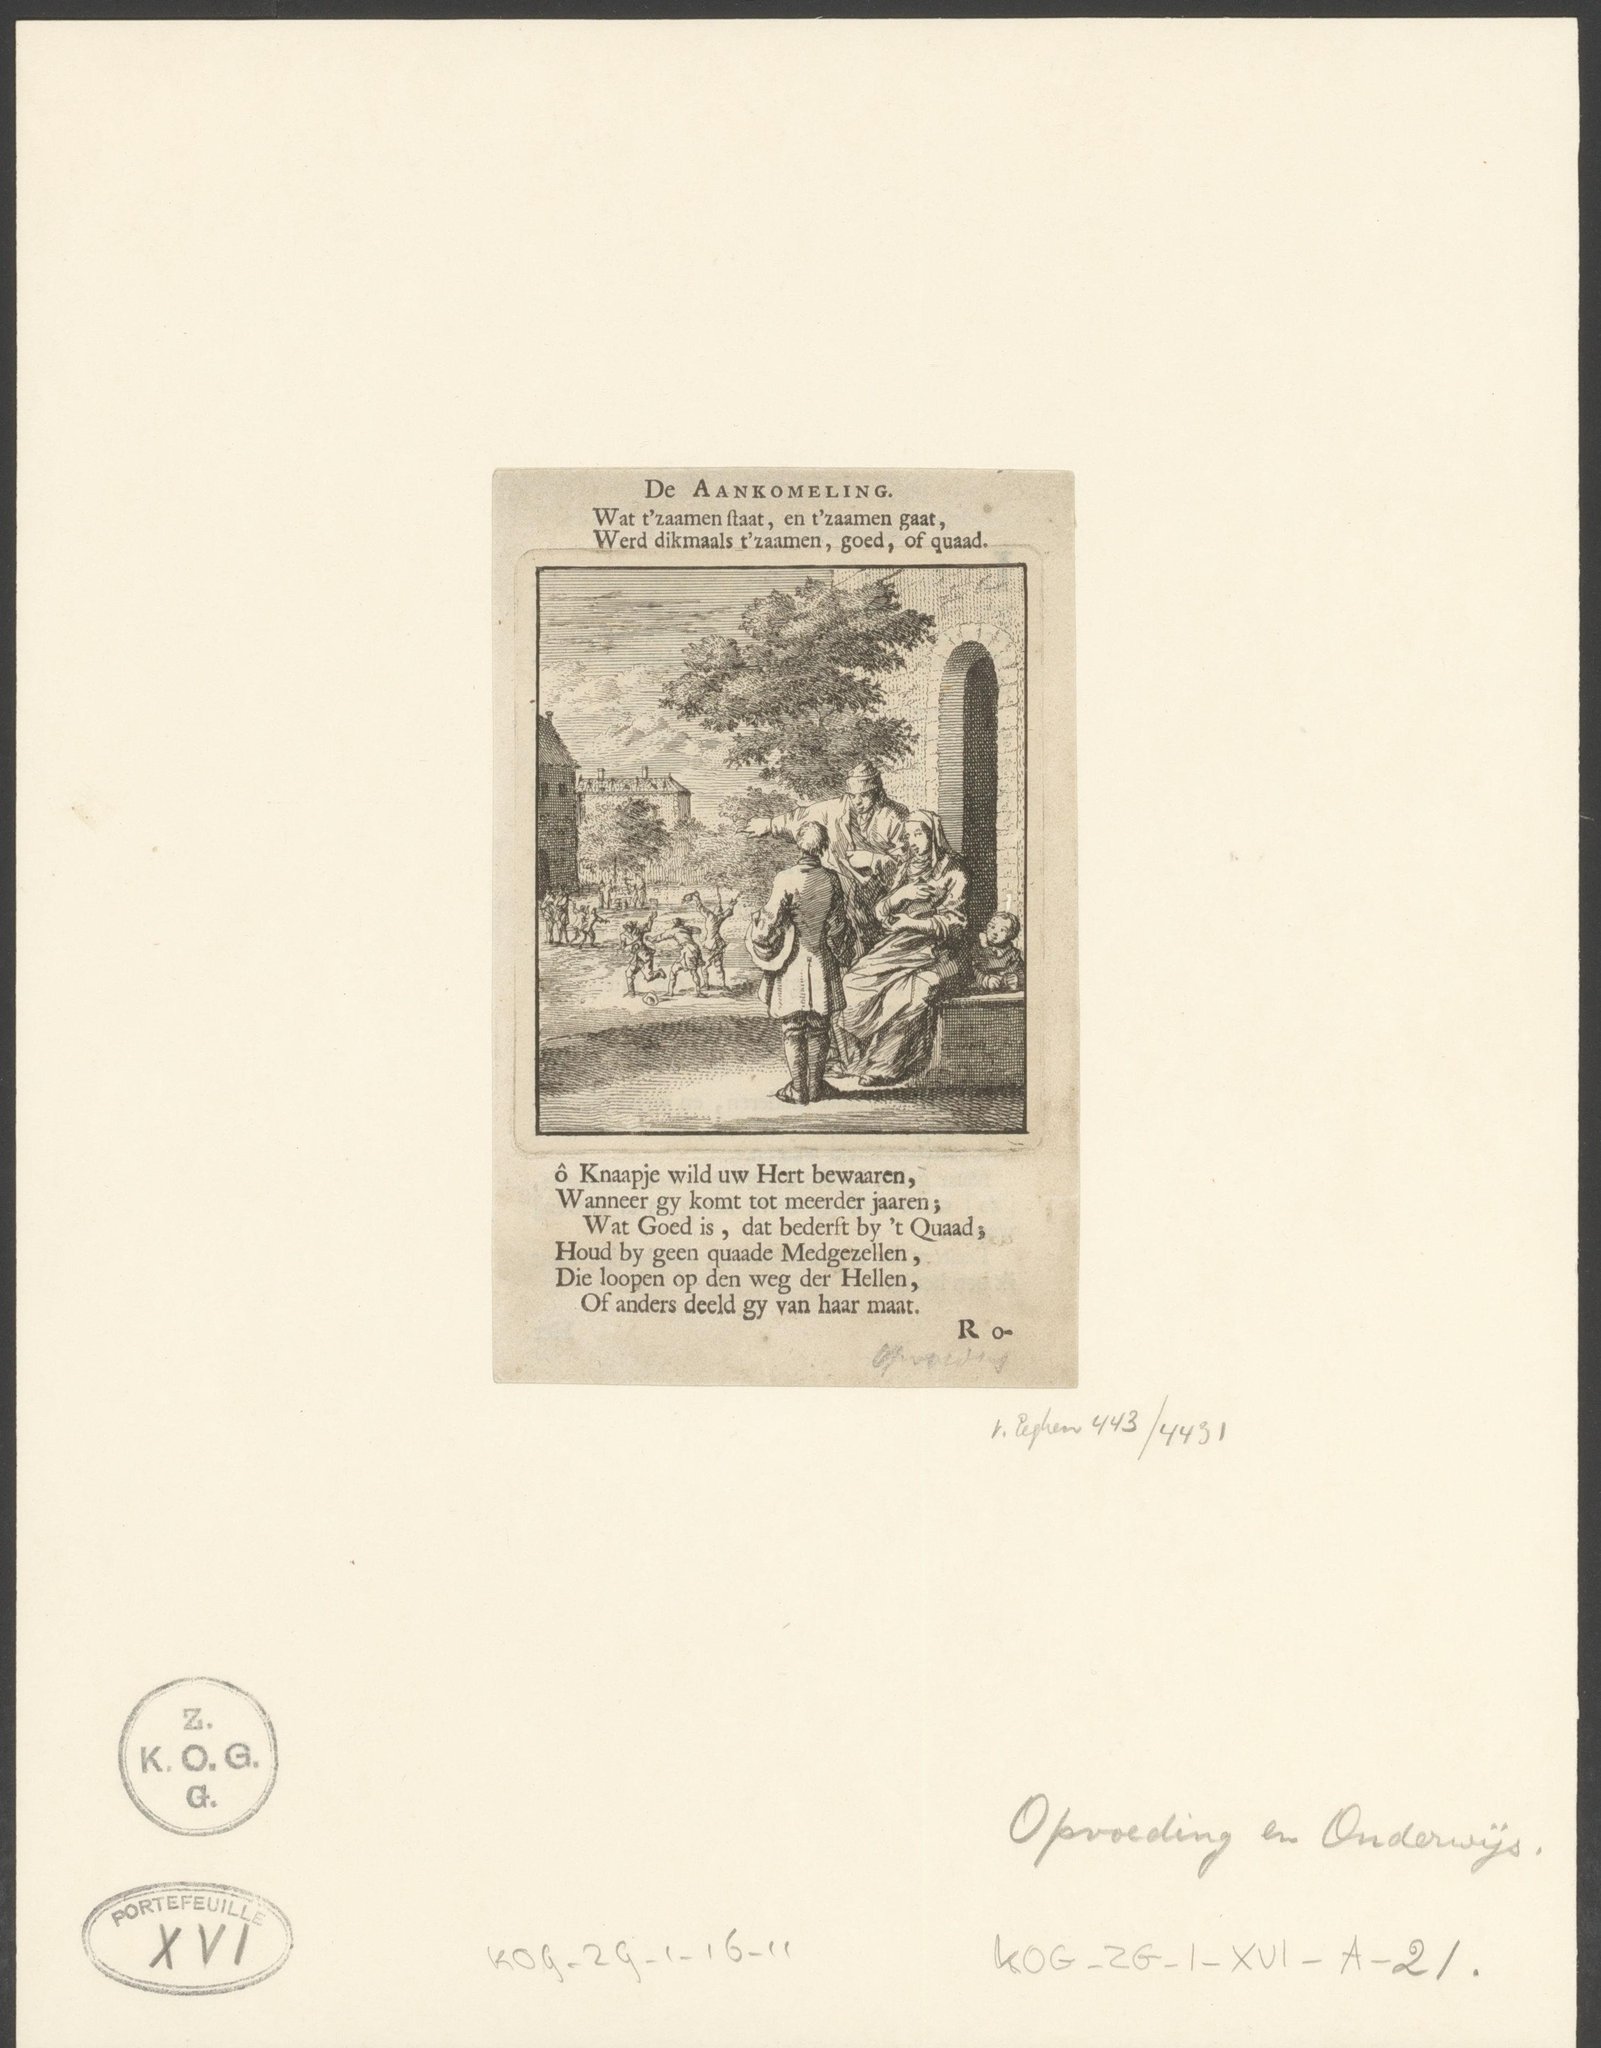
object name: book illustration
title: Vader wijst zijn zoon op spelende kinderen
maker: jan luyken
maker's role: draughtsman, print maker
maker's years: 1649-1712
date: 1712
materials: paper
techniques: etching, letterpress printing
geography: amsterdam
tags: children's games and plays, index finger forwards, pointing, indicating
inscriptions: collector's mark: Lugt 1641, stamp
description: Prent uit: Luyken, Jan. Des menschen begin, midden en einde (...). Amsterdam: Weduwe Pieter Arentsz II en Cornelis van der Sys, 1712, p. 95. Prent ook gebruikt in een latere publicatie (1719).